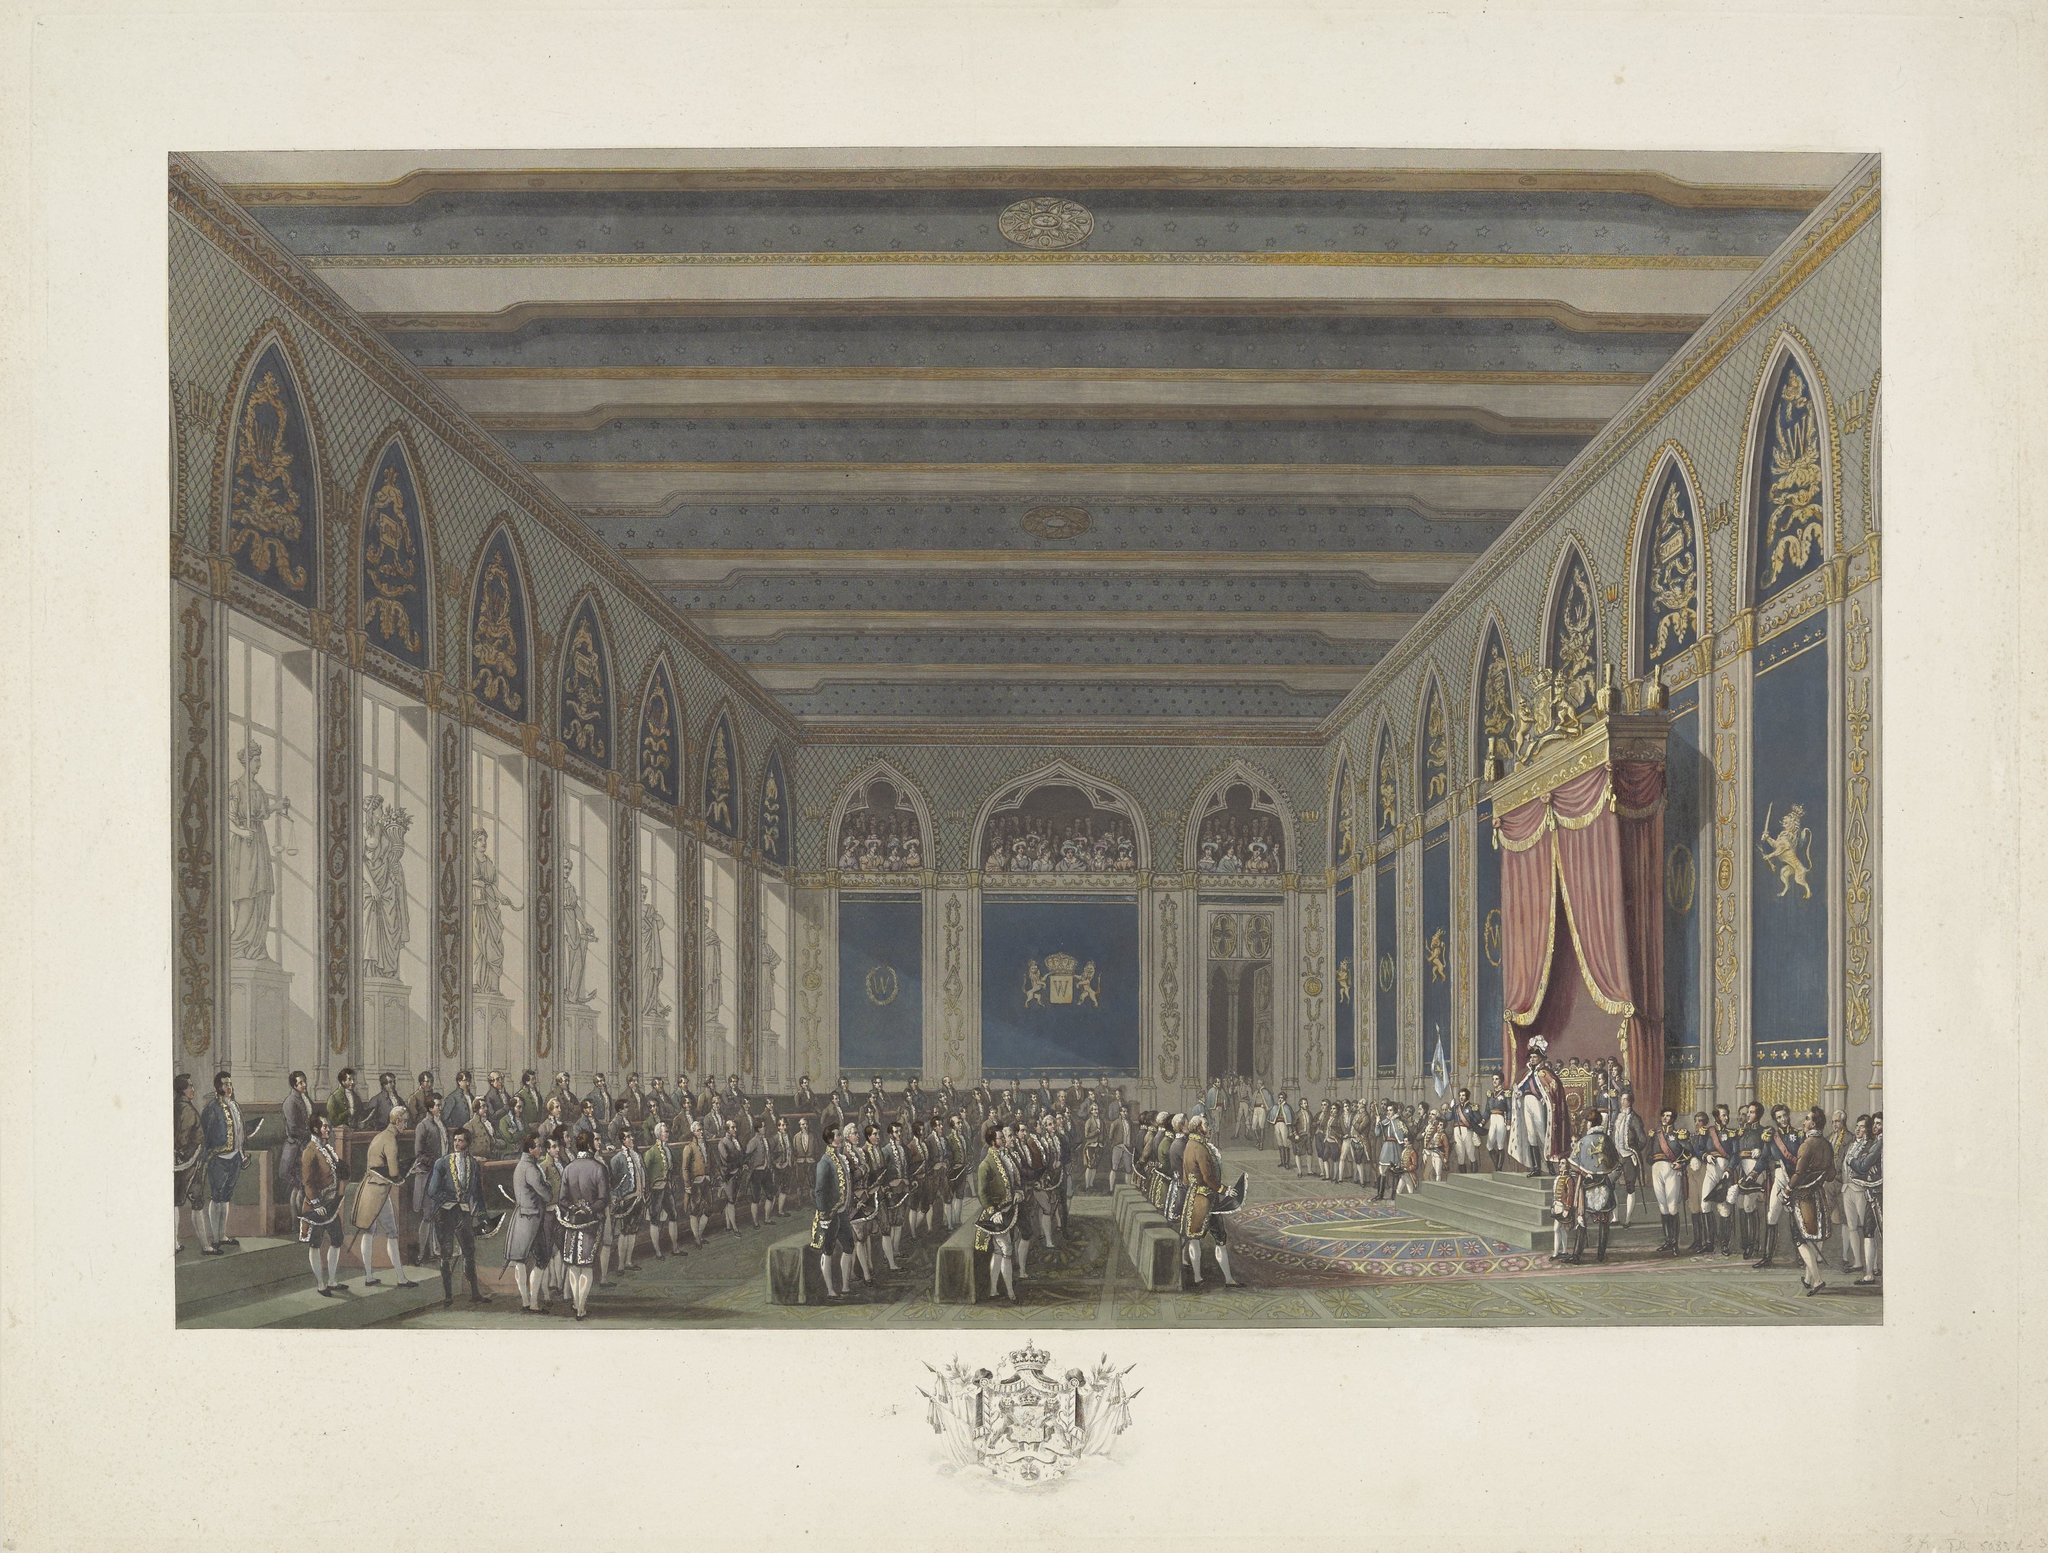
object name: print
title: Twaalf platen van de aankomst en inhuldiging van Willem I in Brussel en de slagen bij Quatre-Bras en Waterloo in 1815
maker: johann nepomuk gibèle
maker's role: print maker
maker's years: 1775-1836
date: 1825-1826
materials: paper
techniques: aquatint, etching, hand coloring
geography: brussels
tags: the hague, berlin, william i of the netherlands, ceremonial celebration of installation of a ruler, popular representation ~ government, brussels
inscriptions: collector's mark: Lugt 2228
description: Instelling van de Staten-Generaal door koning Willem I te Brussel op 21 september 1815. Onderaan het wapen van koning Willem I. Onderdeel van een serie platen van de aankomst en inhuldiging van Willem I in Brussel.